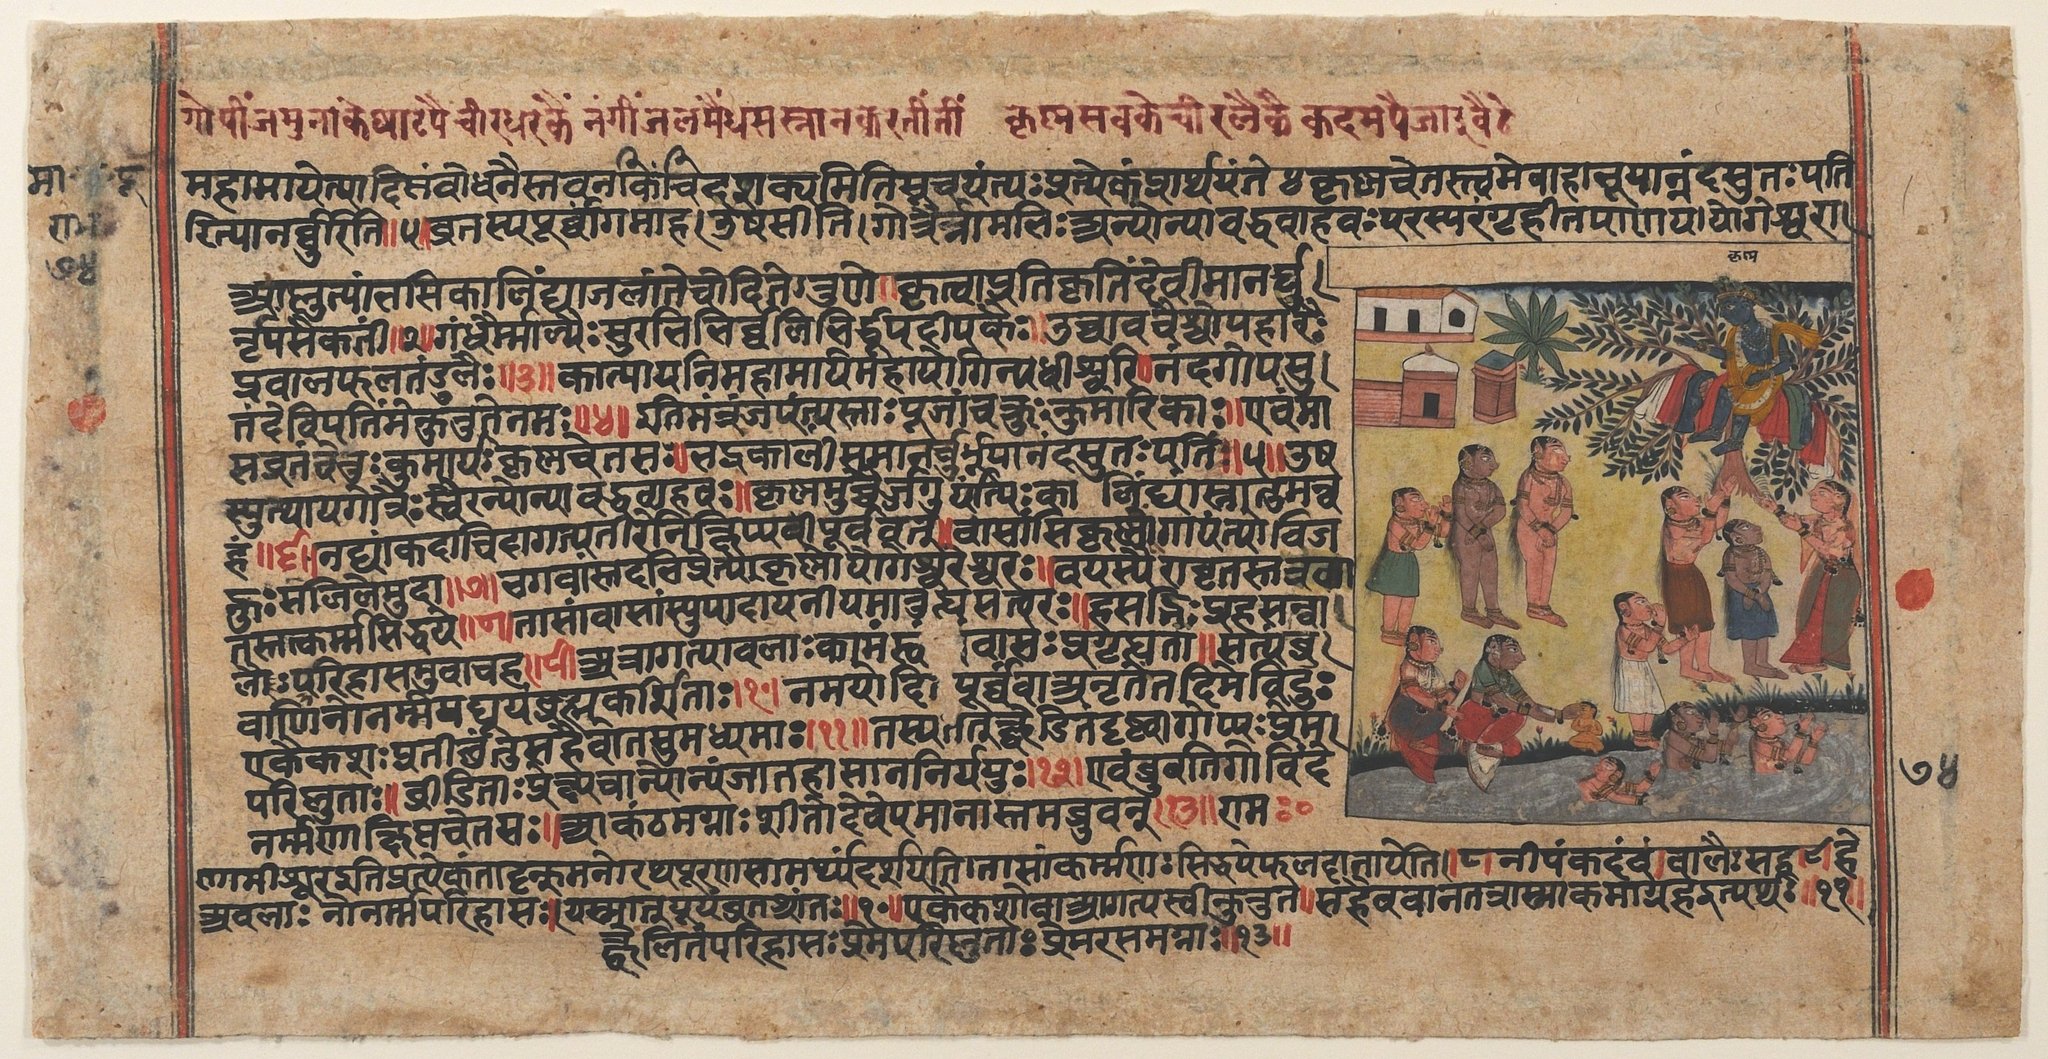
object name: folio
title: Krishna Steals the Gopis’ Clothing: Page from a Dispersed Bhagavata Purana Manuscript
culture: mewar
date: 1620-1630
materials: ink, paper, watercolor